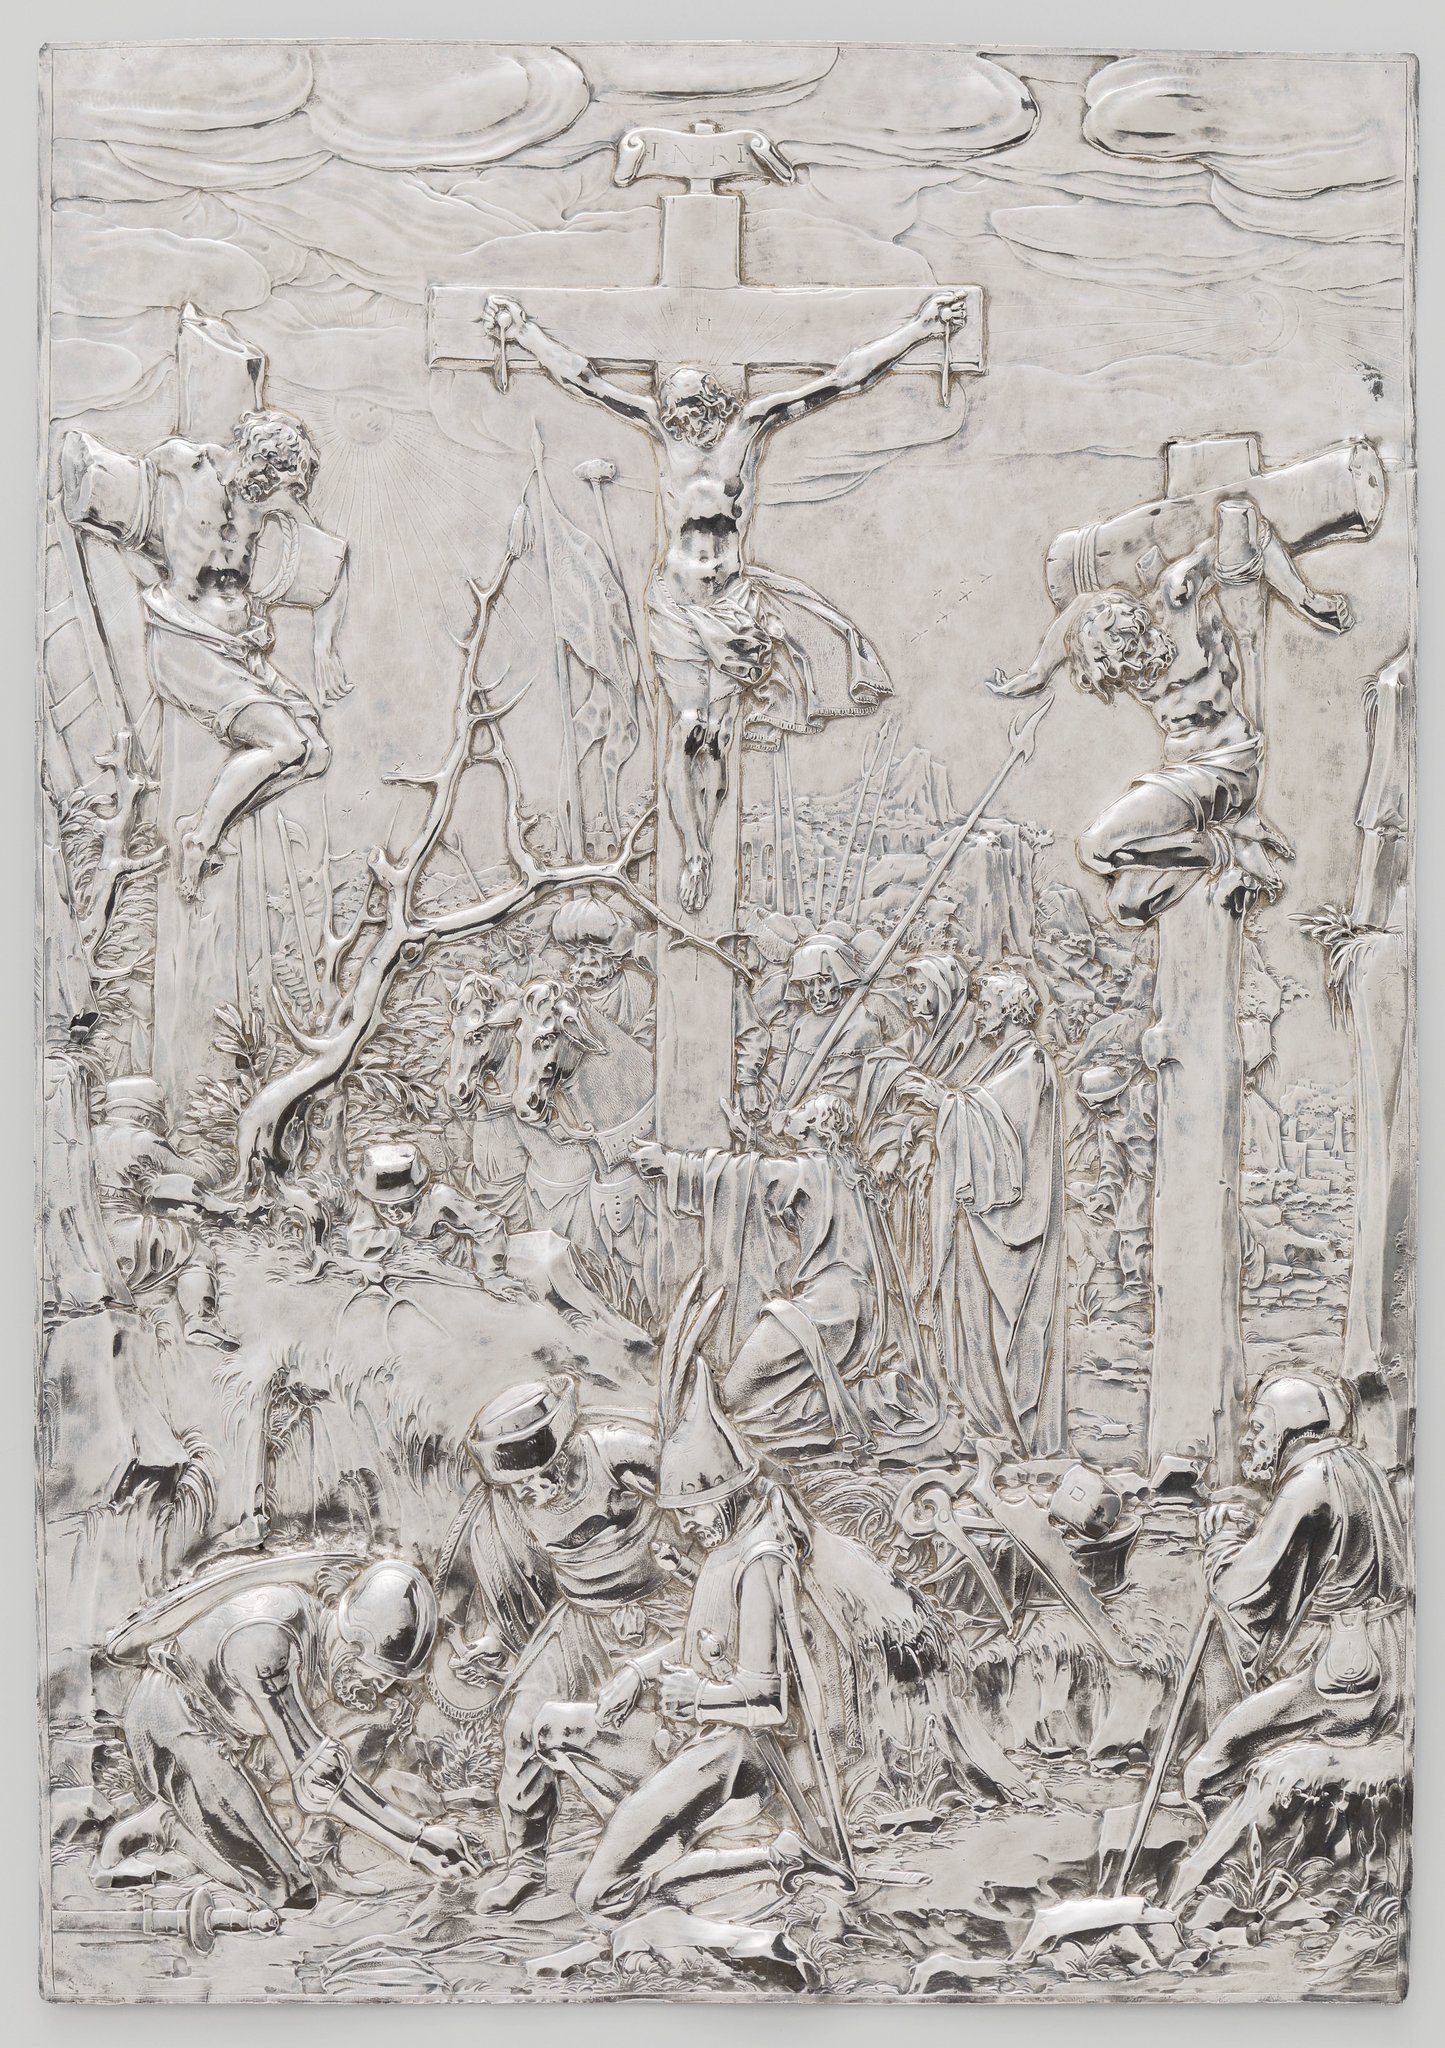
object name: plaque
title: The Crucifixion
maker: arent van bolten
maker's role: draughtsman, print maker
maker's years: 1573-1633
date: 1610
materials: silver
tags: soldiers throwing dice for christ's seamless garment ~ christ's death on the cross, crucified christ, with particular persons under the cross - dd - the three crosses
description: Een zilveren gedreven plaquette met een voorstelling van de Kruisiging. In het midden Christus aan het kruis. Aan de voet van het kruis knielt Maria Magdalena, ter rechterzijde staan Maria en Johannes.